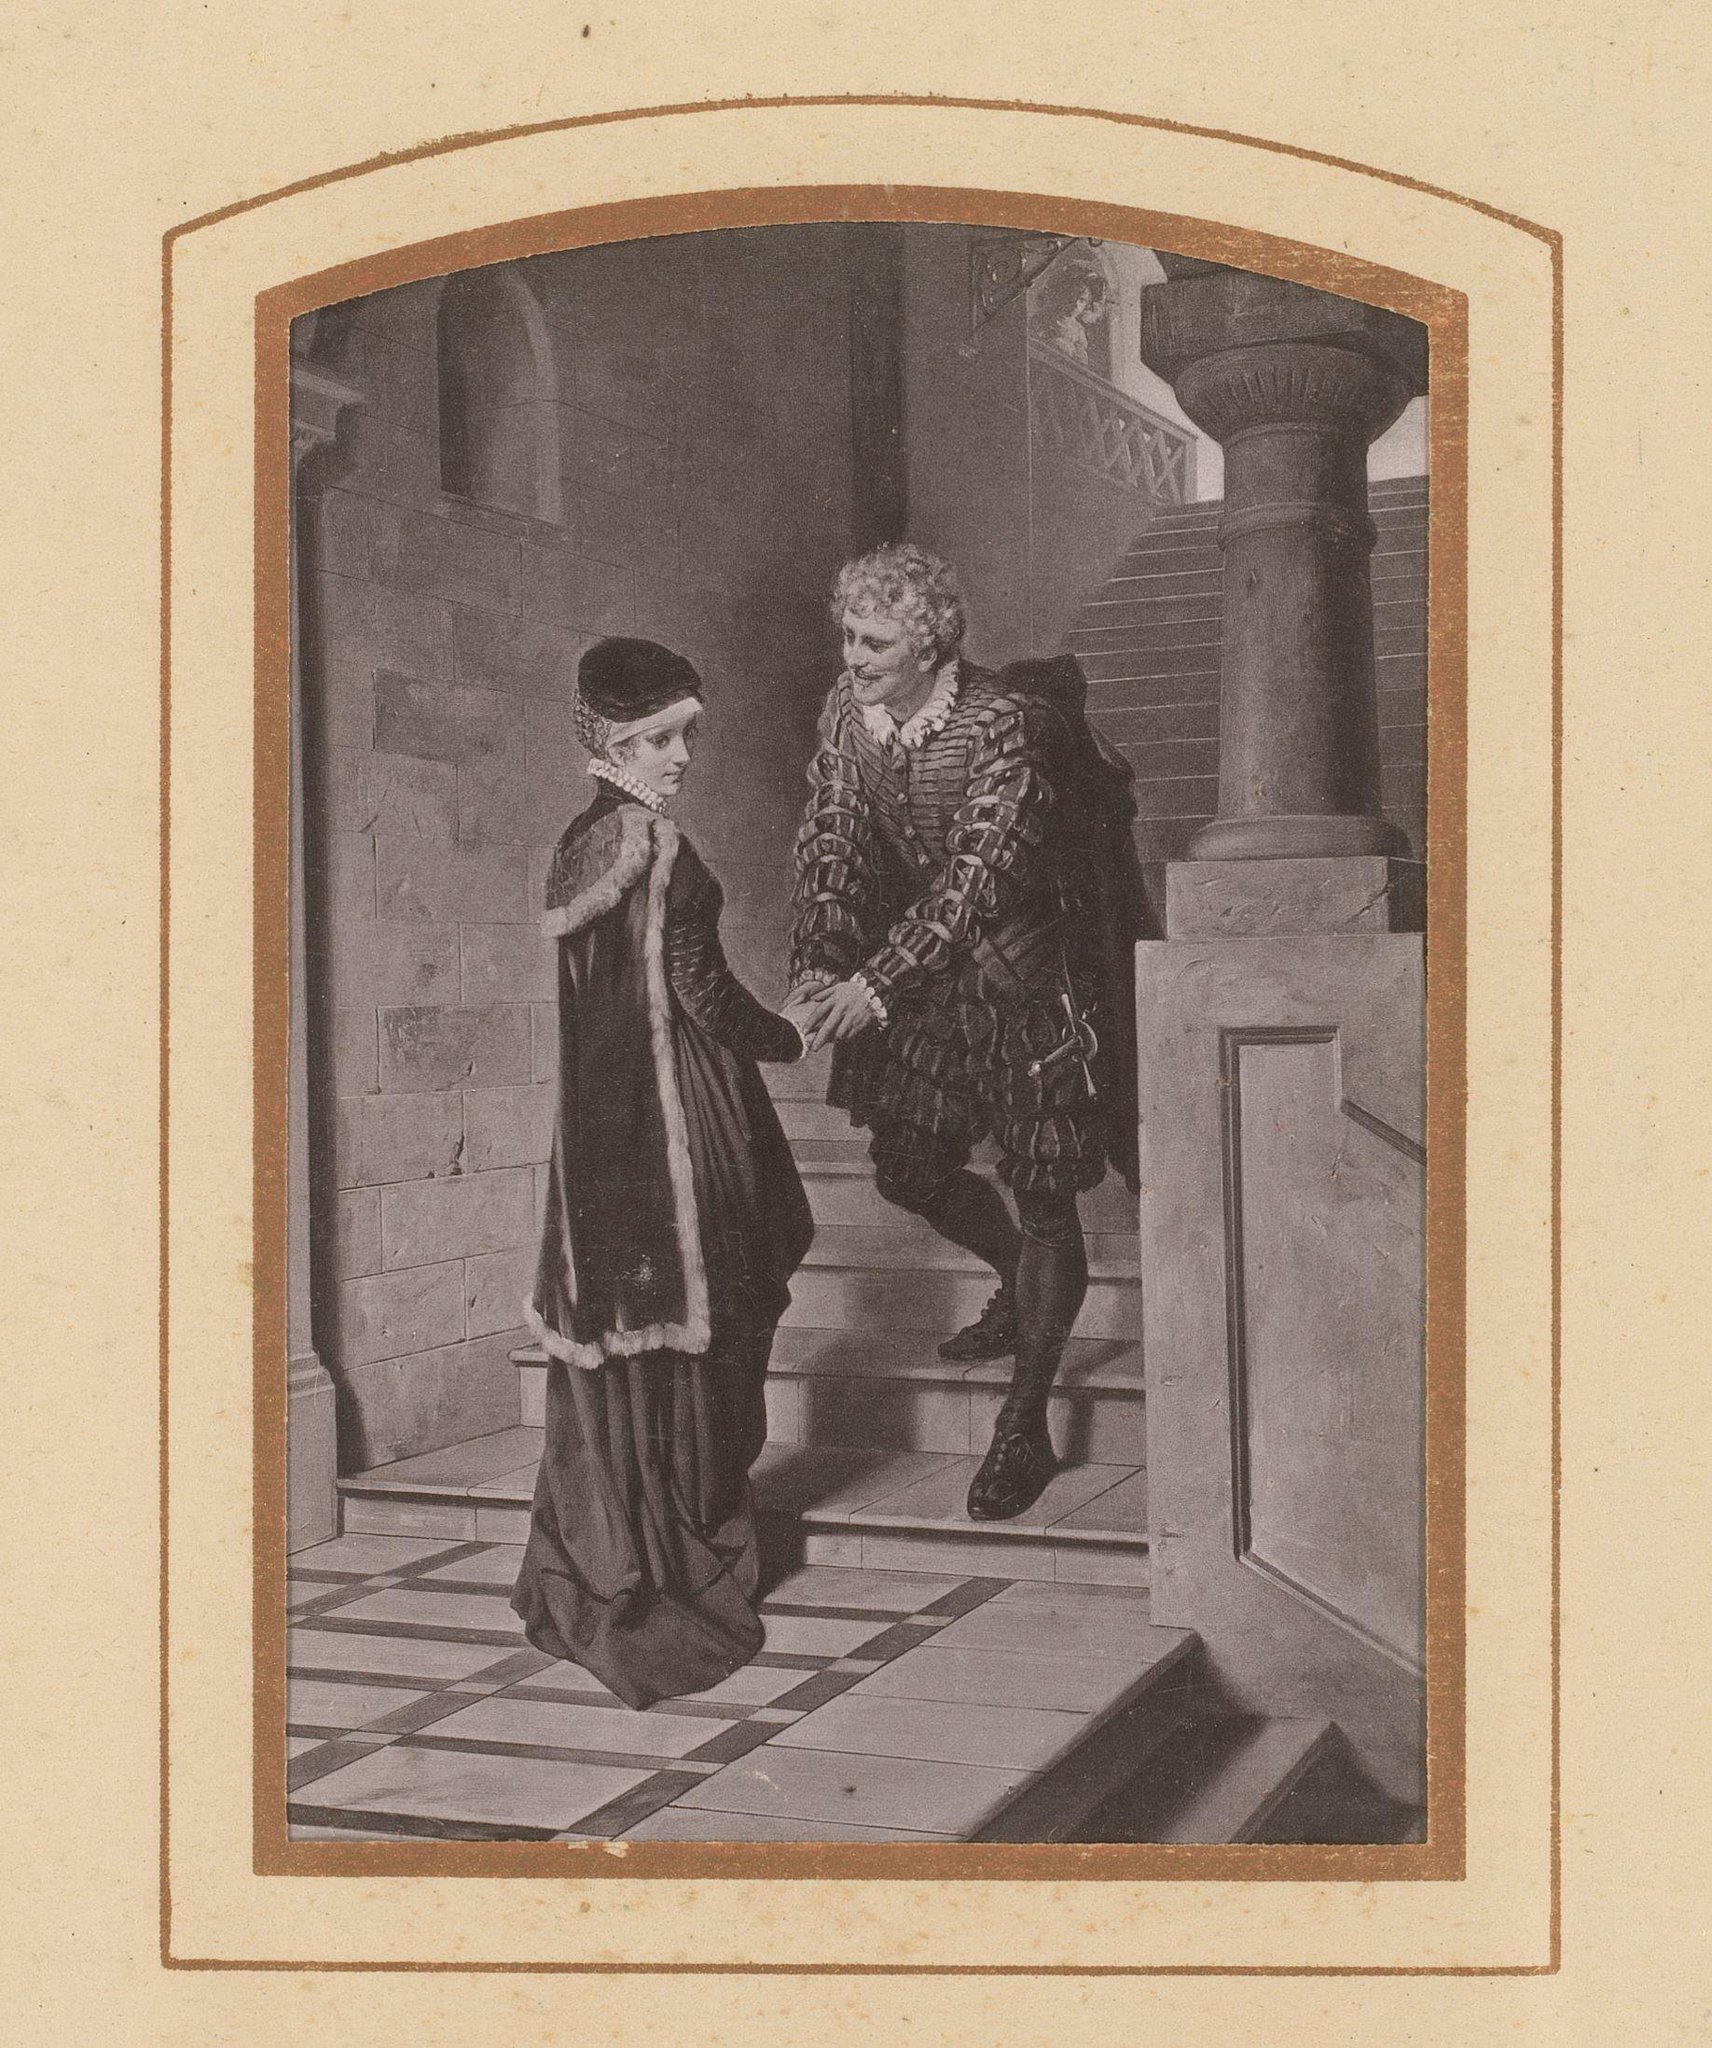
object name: cabinet photograph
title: Georg begegnet Maria an der Treppe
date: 1870-1900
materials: cardboard, paper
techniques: photograph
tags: adult woman, adult man, staircase, lovers' meeting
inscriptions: inscription: ‘EBERS-GALLERIE Nr. 16.’, inscription: ‘Die Frau Bürgemeisterin. Kap. 22./ Hermann Kaulbach fec. - Vervielfältigung vorbehalten./ FR. BRÜCKMANN PHOT./ Deutsche Verlags-Anstalt (vormals Eduard Hallberger) Stuttgart und Leipzig.’, retailer's mark: ‘L. J. FRANCHIMONT/ Boek- muziek-/ en kunsthandel/ 70 Bakkerstraat/ ARNHEM’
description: Deze prent maakt deel uit van een album.